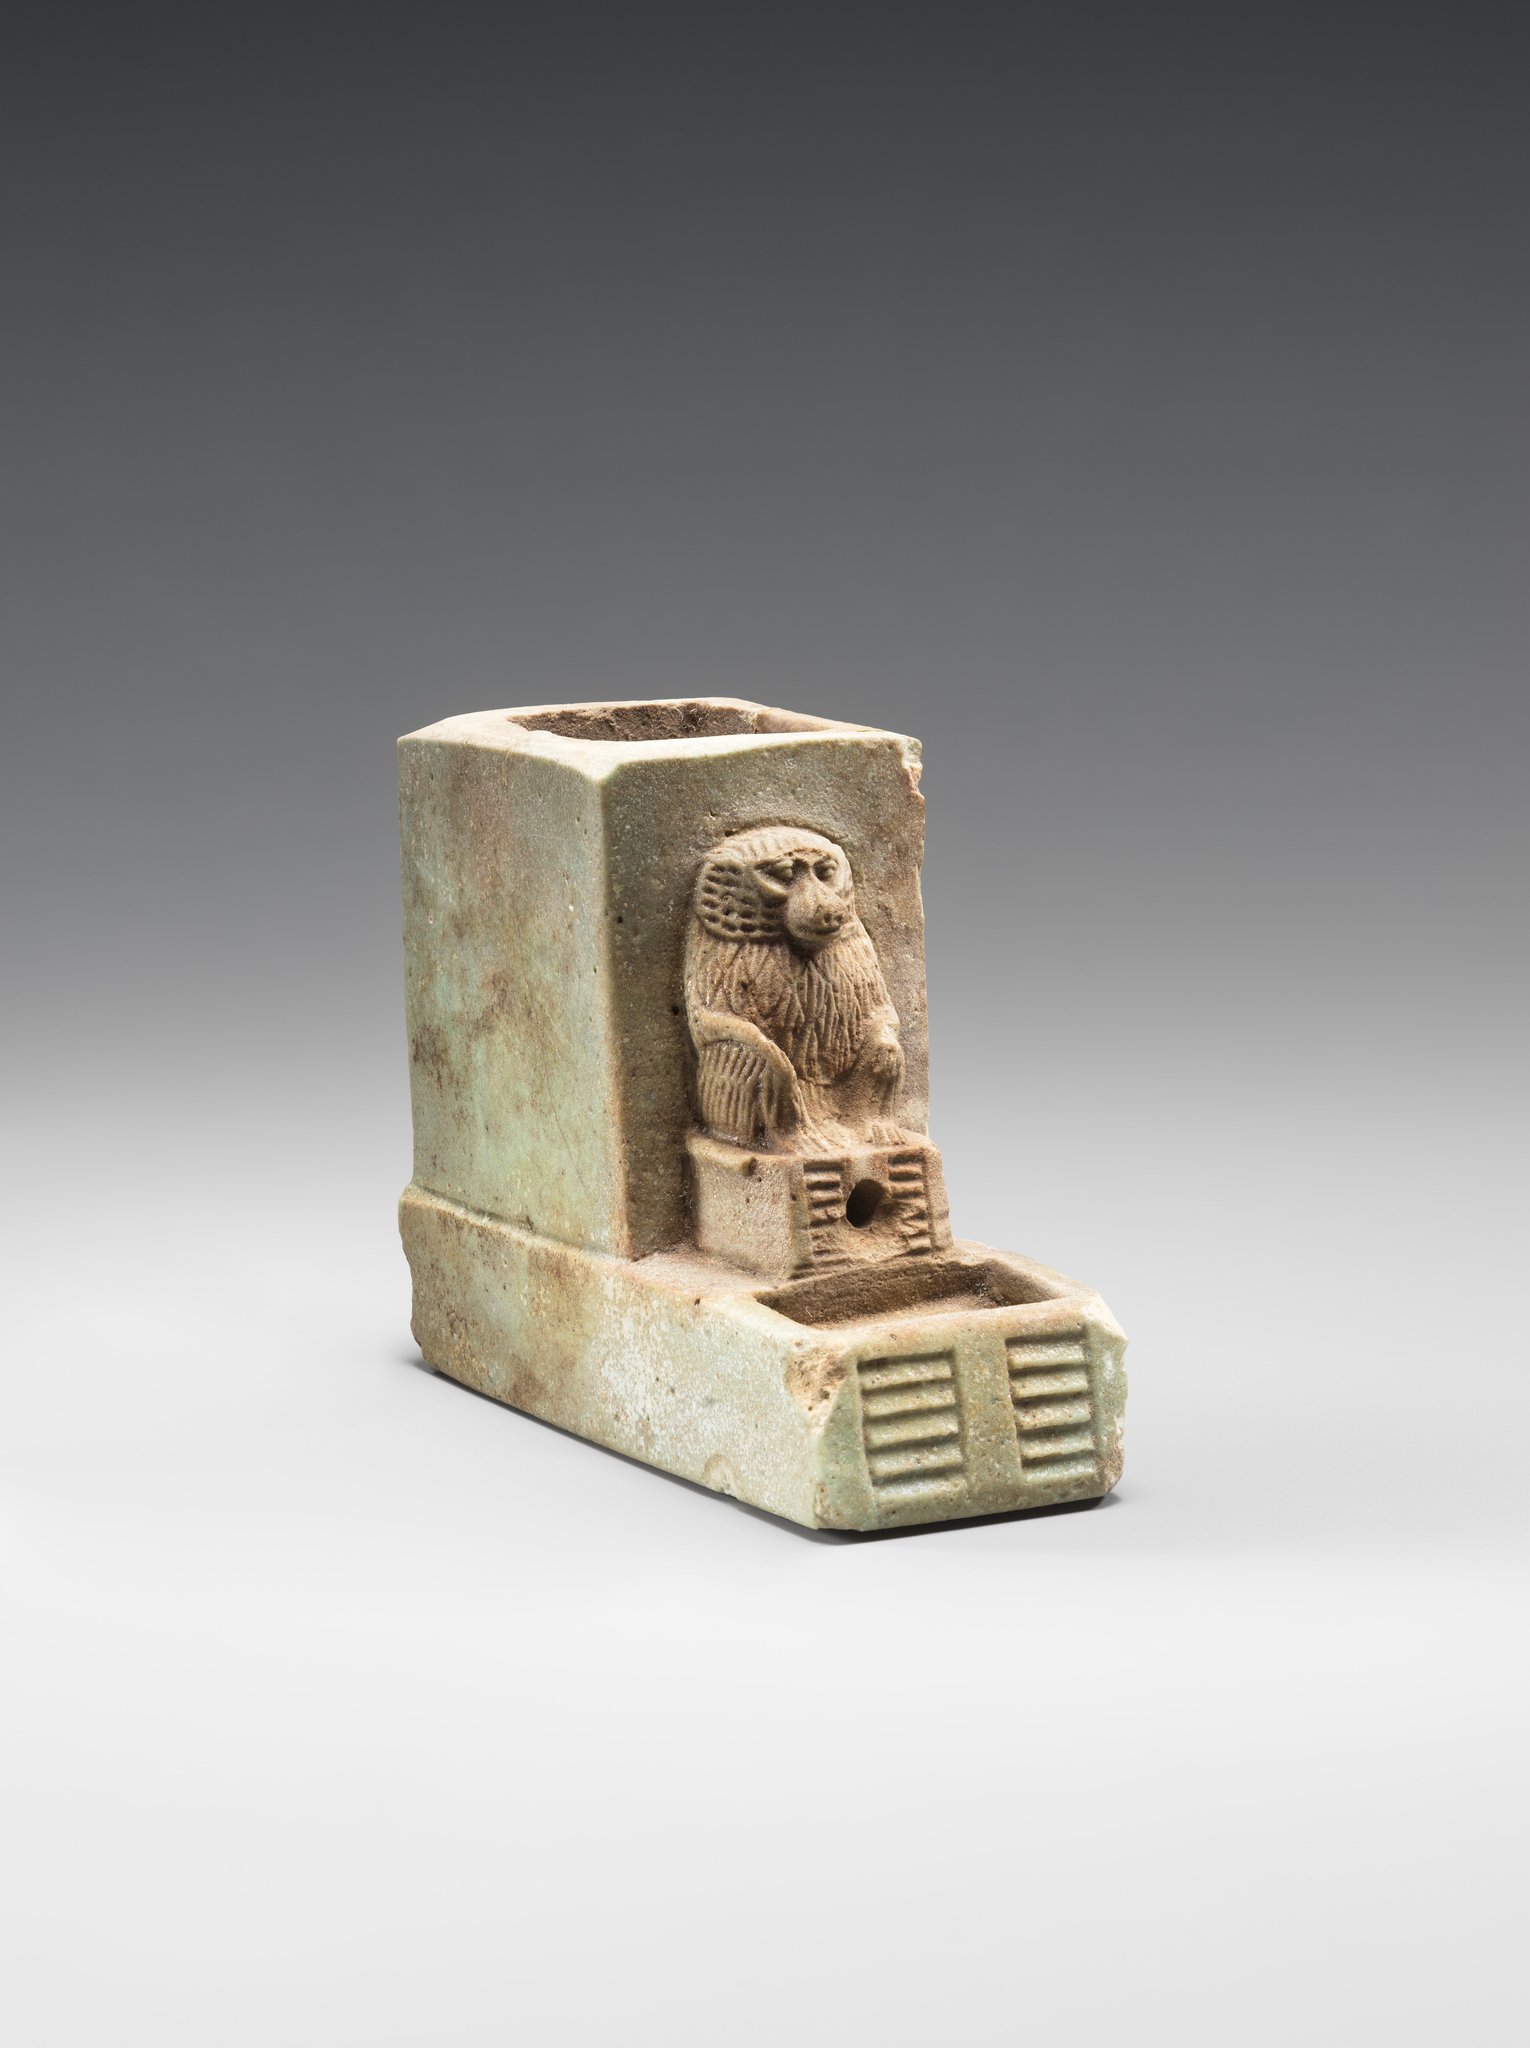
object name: clepsydra, water clock model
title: Water Clock Decorated with a Baboon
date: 664-630 BCE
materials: faience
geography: egypt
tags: baboons